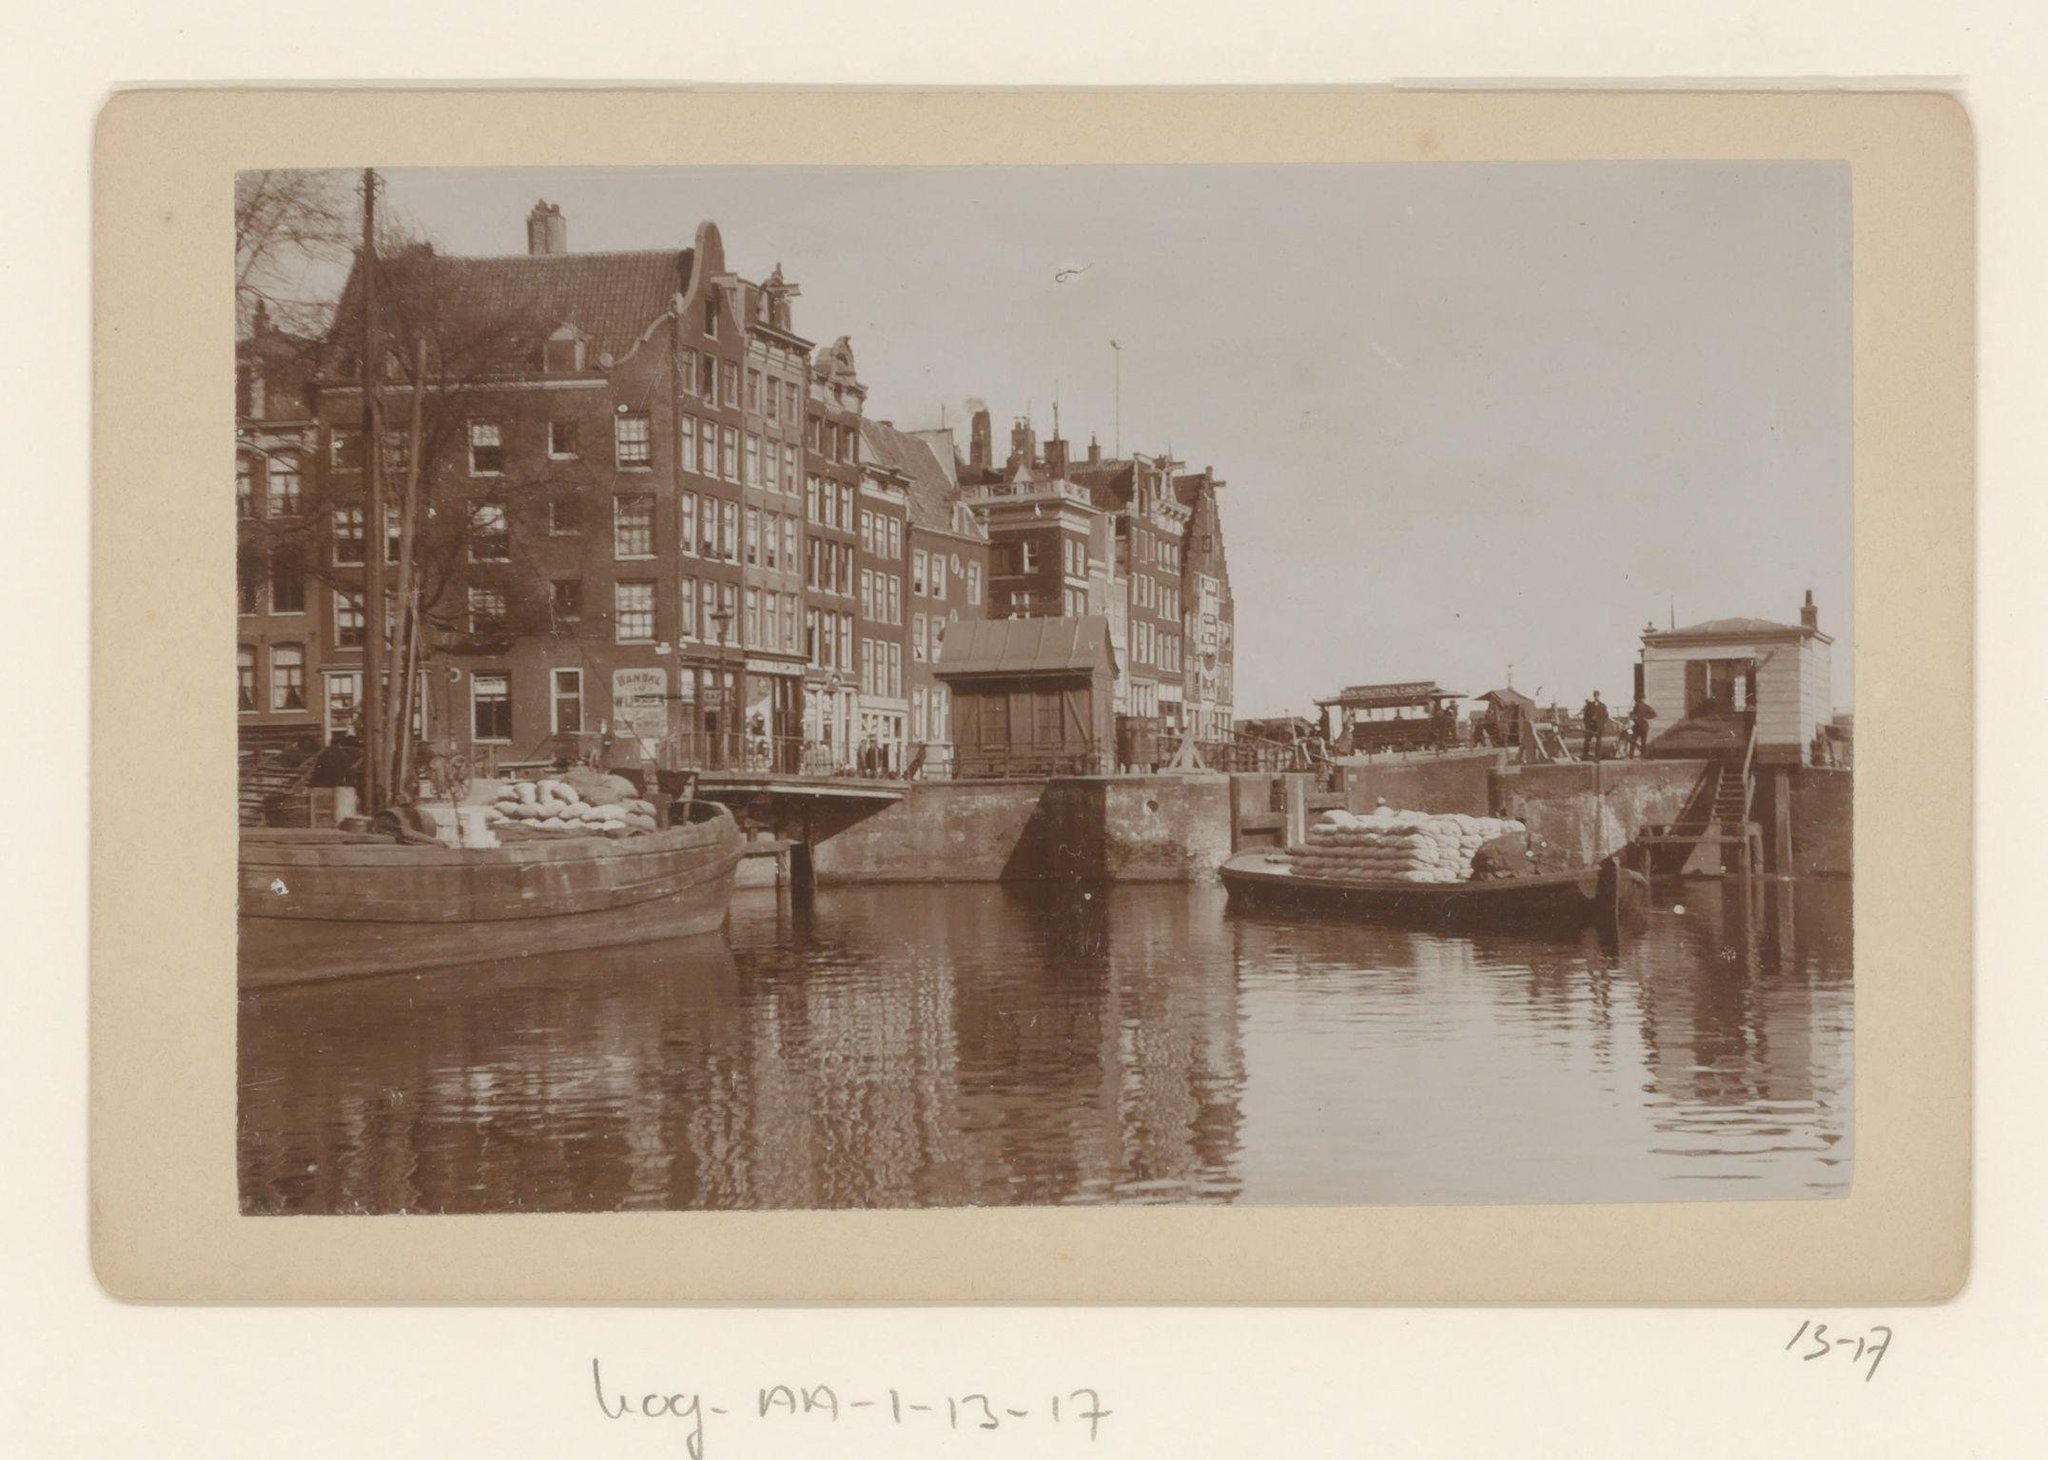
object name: cabinet photograph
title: Gezicht op de Korte Singel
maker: Anonymous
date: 1865-1940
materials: paper, cardboard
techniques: collodion silver print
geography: amsterdam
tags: city-view in general; 'veduta', canal, the usual house or row of houses, bridge in city across river, canal, etc.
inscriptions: collector's mark: ‘13,17’ Lugt 1641b, inscription: ‘no 41 Korte Singel’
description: Onderwerpsrubriek binnen de Atlas Amsterdam: Oude Schans, Schoutensteeg, Singel (Korte), Singel.